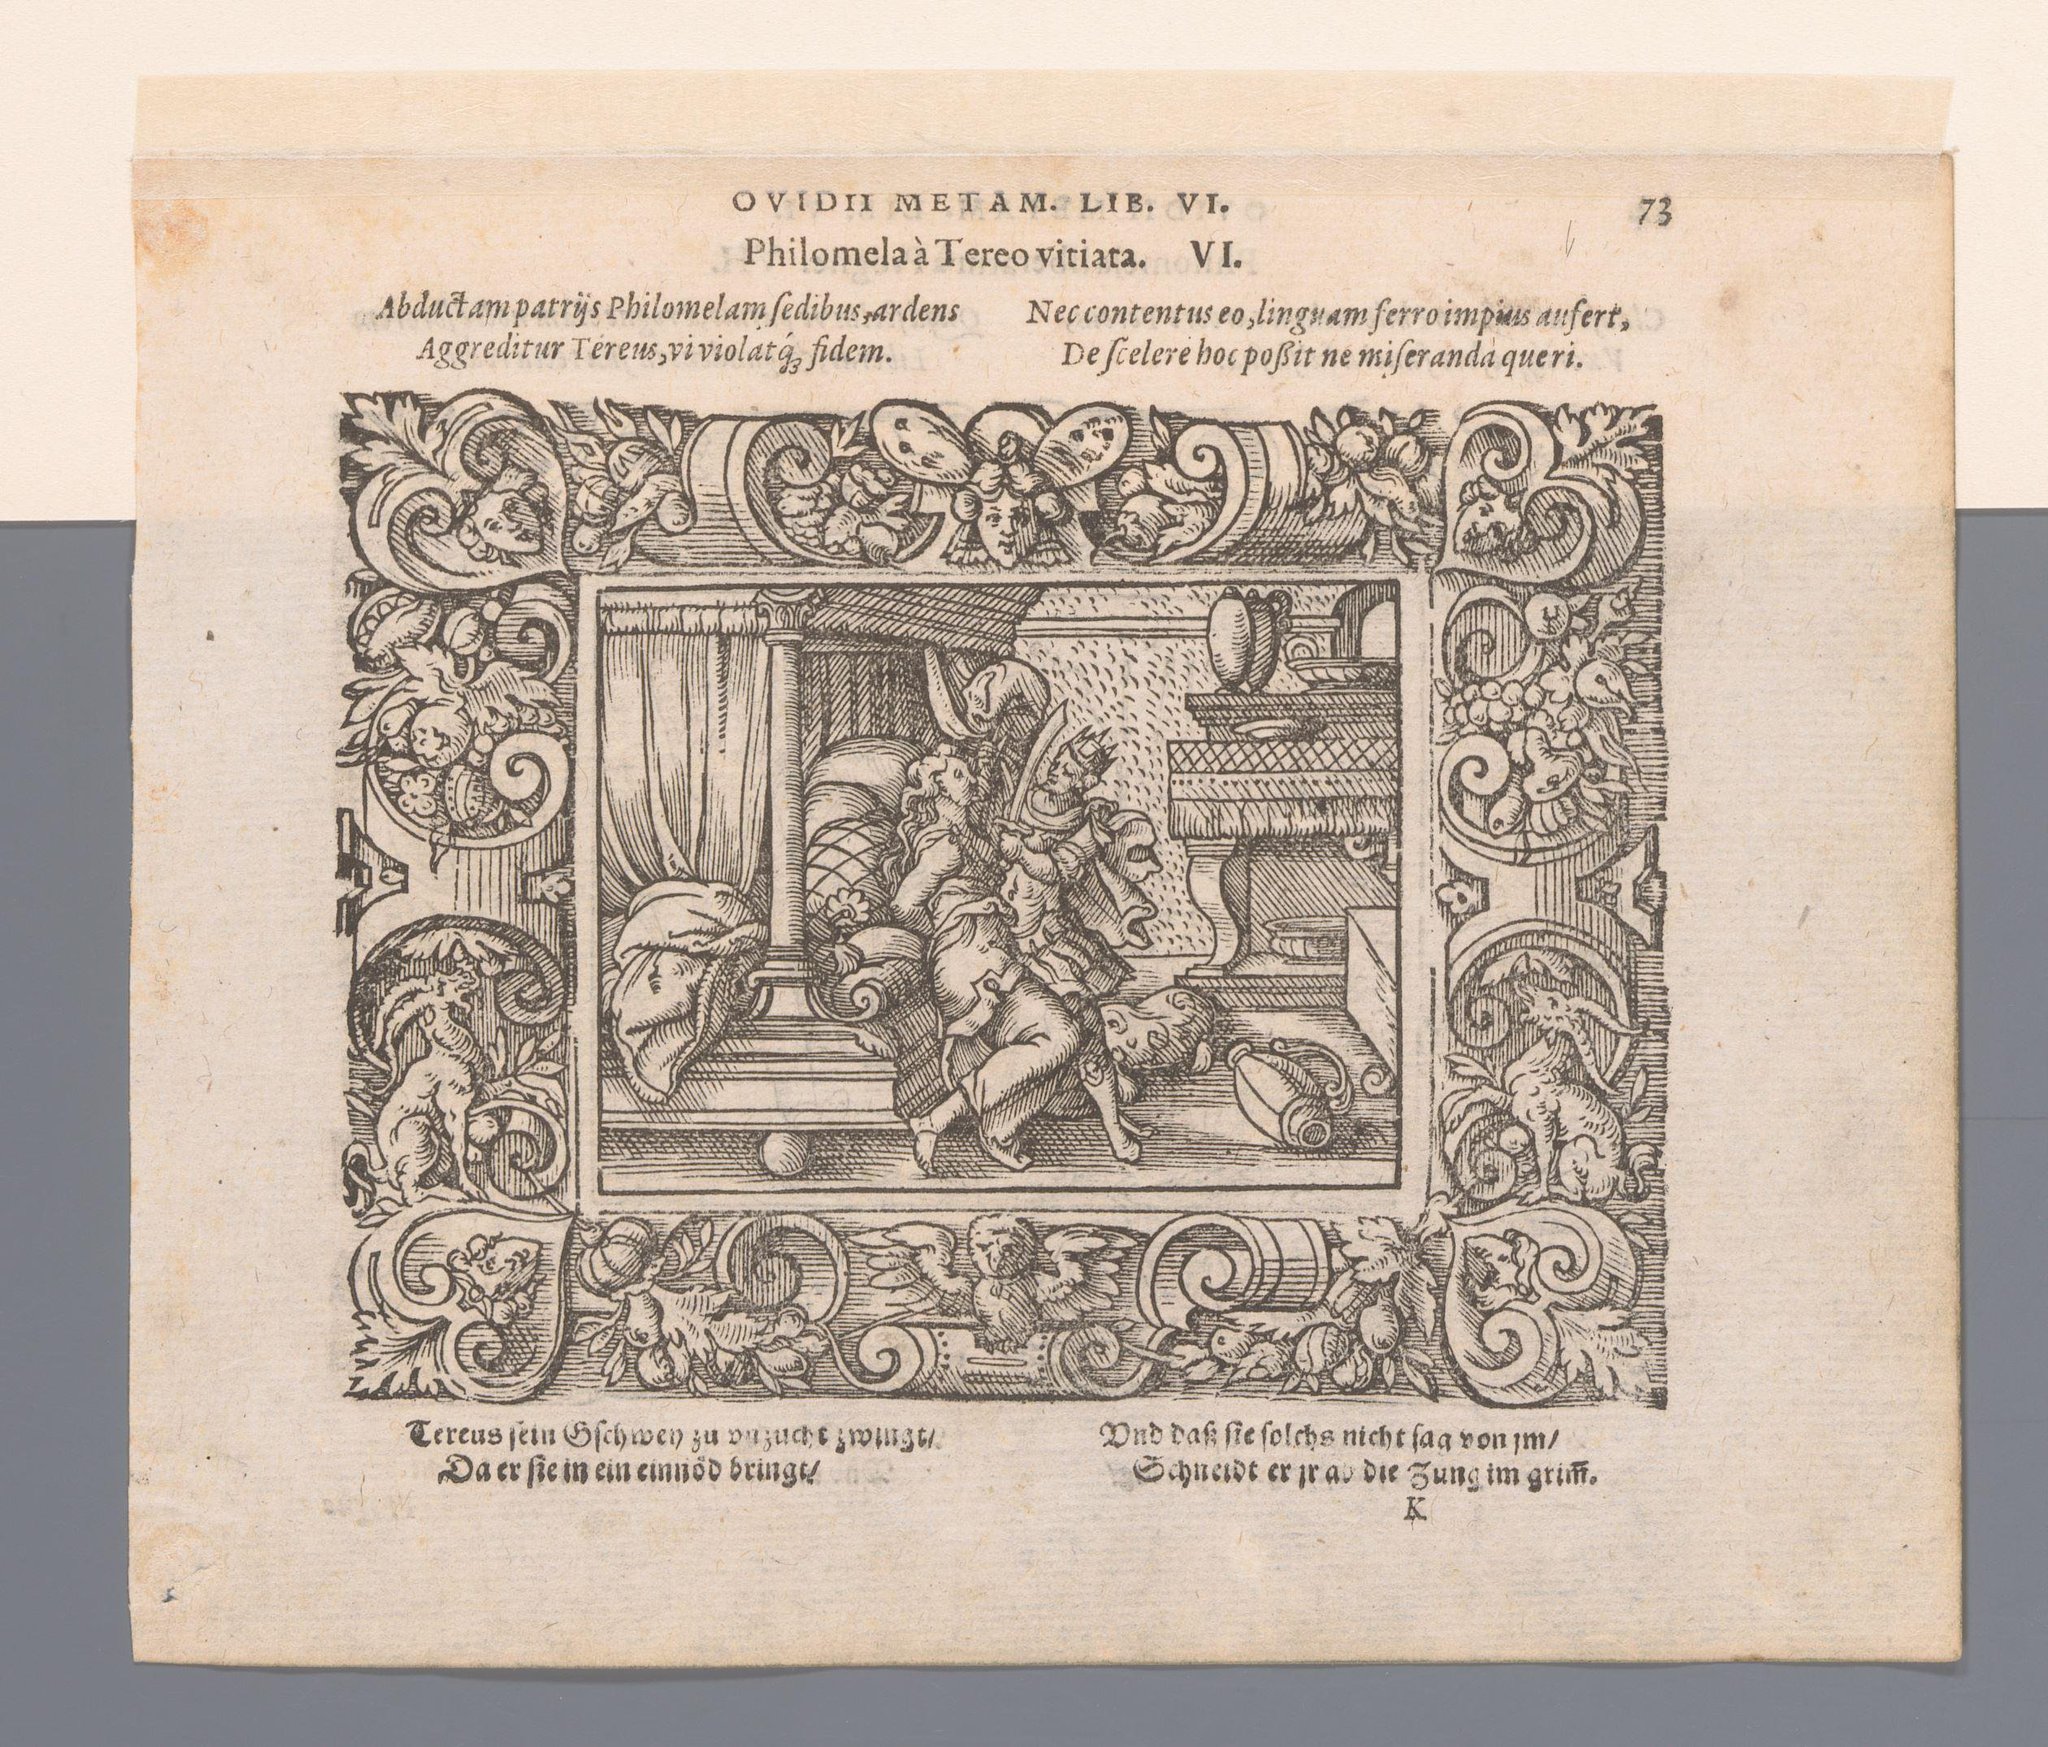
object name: print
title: Philomela à Tereo vitiata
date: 1569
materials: paper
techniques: letterpress printing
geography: frankfurt am main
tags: tereus cuts out philomela's tongue, and hides her in a lonely place, scrollwork, strapwork ~ ornament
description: Illustratie bij de Metamorfosen van Ovidius, afkomstig uit de publicatie: Posthius, Johannes. Tetrasticha in Ovidii metam. Frankfurt am Main: Georg Rab en Sigmund Feyerabend en erven Weigand Han, 1569. De voorstellingen en ornamentranden van deze boekillustraties zijn van twee aparte blokken gedrukt. Beide werden afzonderlijk van elkaar ook gebruikt voor andere publicaties, en de ornamentranden werden eveneens binnen deze publicatie meerdere keren gebruikt.